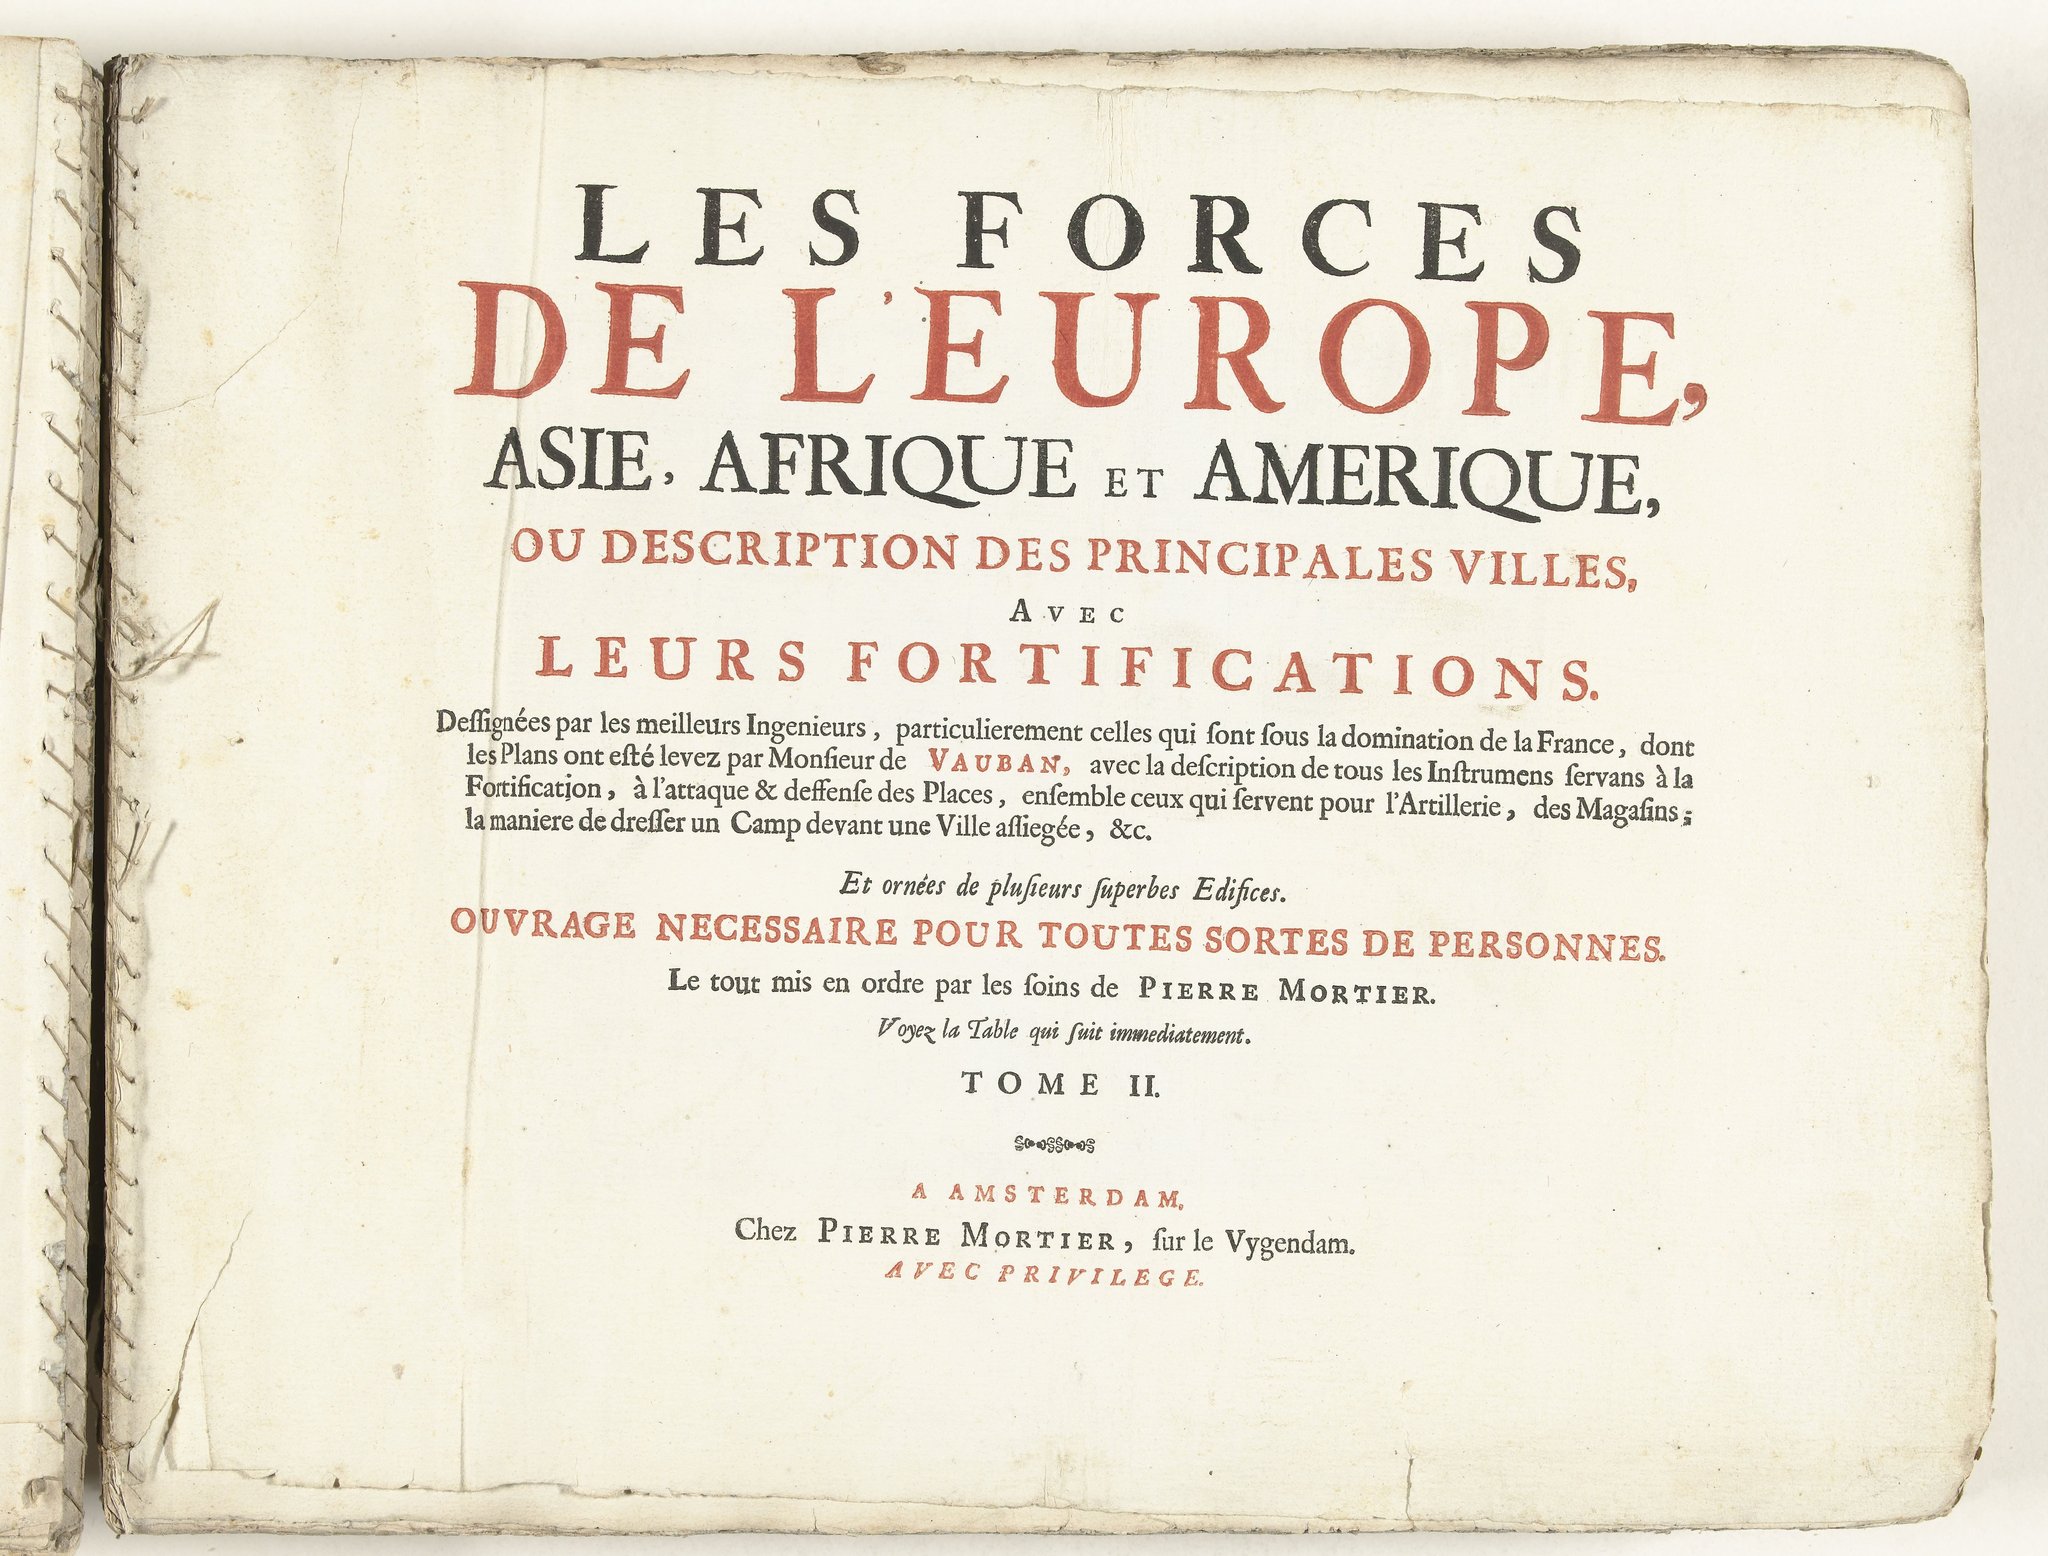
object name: titelblad, titelpagina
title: Titelpagina voor het tweede deel van het prentwerk: Les Forces de l'Europe, Asie, Afrique et Amerique, ca. 1702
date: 1702-1703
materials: paper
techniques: letterpress printing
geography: amsterdam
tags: spaanse successieoorlog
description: Titelpagina gedrukt in zwart en rood voor het tweede van twaalf delen van het prentwerk: Les Forces de l'Europe, Asie, Afrique et Amerique, uitgegeven ca. 1702. Ongenummerd [25]. Het prentwerk bestaat in totaal uit 276 genummerde platen van vermaarde sterke steden en vestingen in het kader van de Spaanse Successieoorlog. Voor het merendeel zijn deze platen gekopieerd naar de anonieme Franse platen: in Les forces de l'Europe en in: Le theatre de la guerre, dans les Pays-Bas, beide oorspronkelijk uitgegeven door Nicolas de Fer te Parijs (1693-1697) in het kader van de Negenjarige Oorlog. Titel in het Frans.